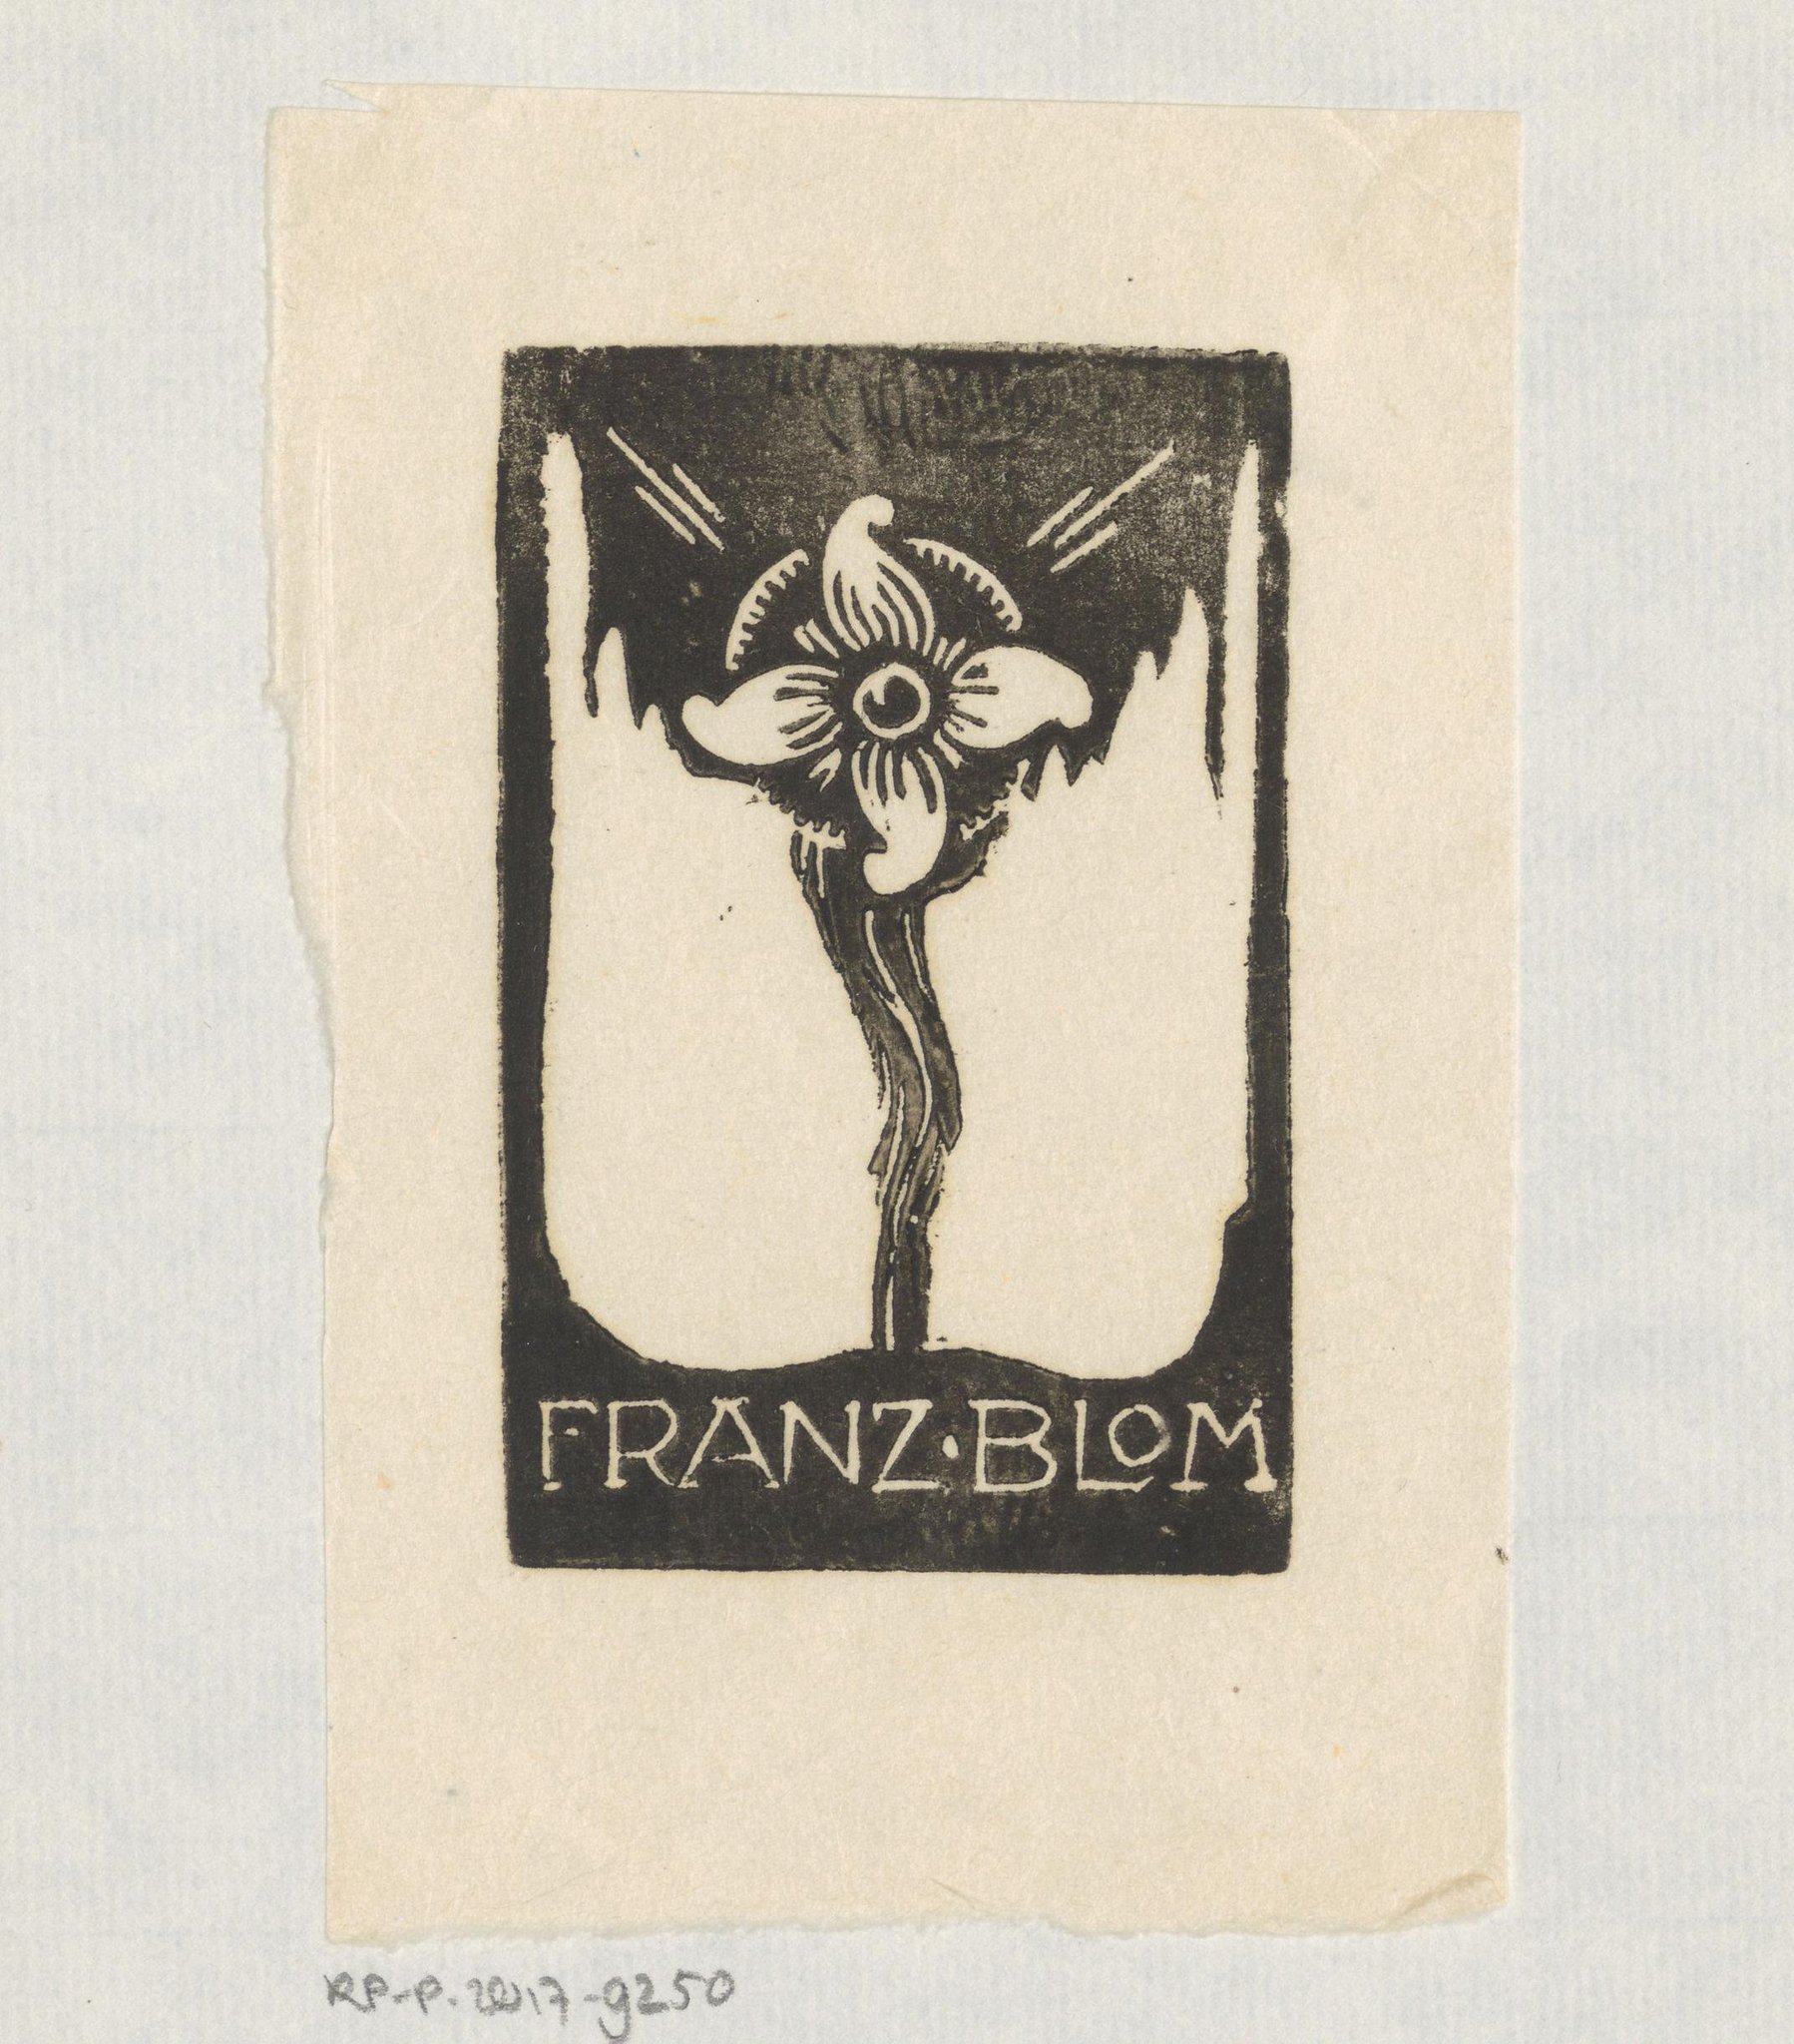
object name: bookplate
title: Ex libris van Franz Blom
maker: Anonymous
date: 1880-1949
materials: paper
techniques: woodcut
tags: flowers